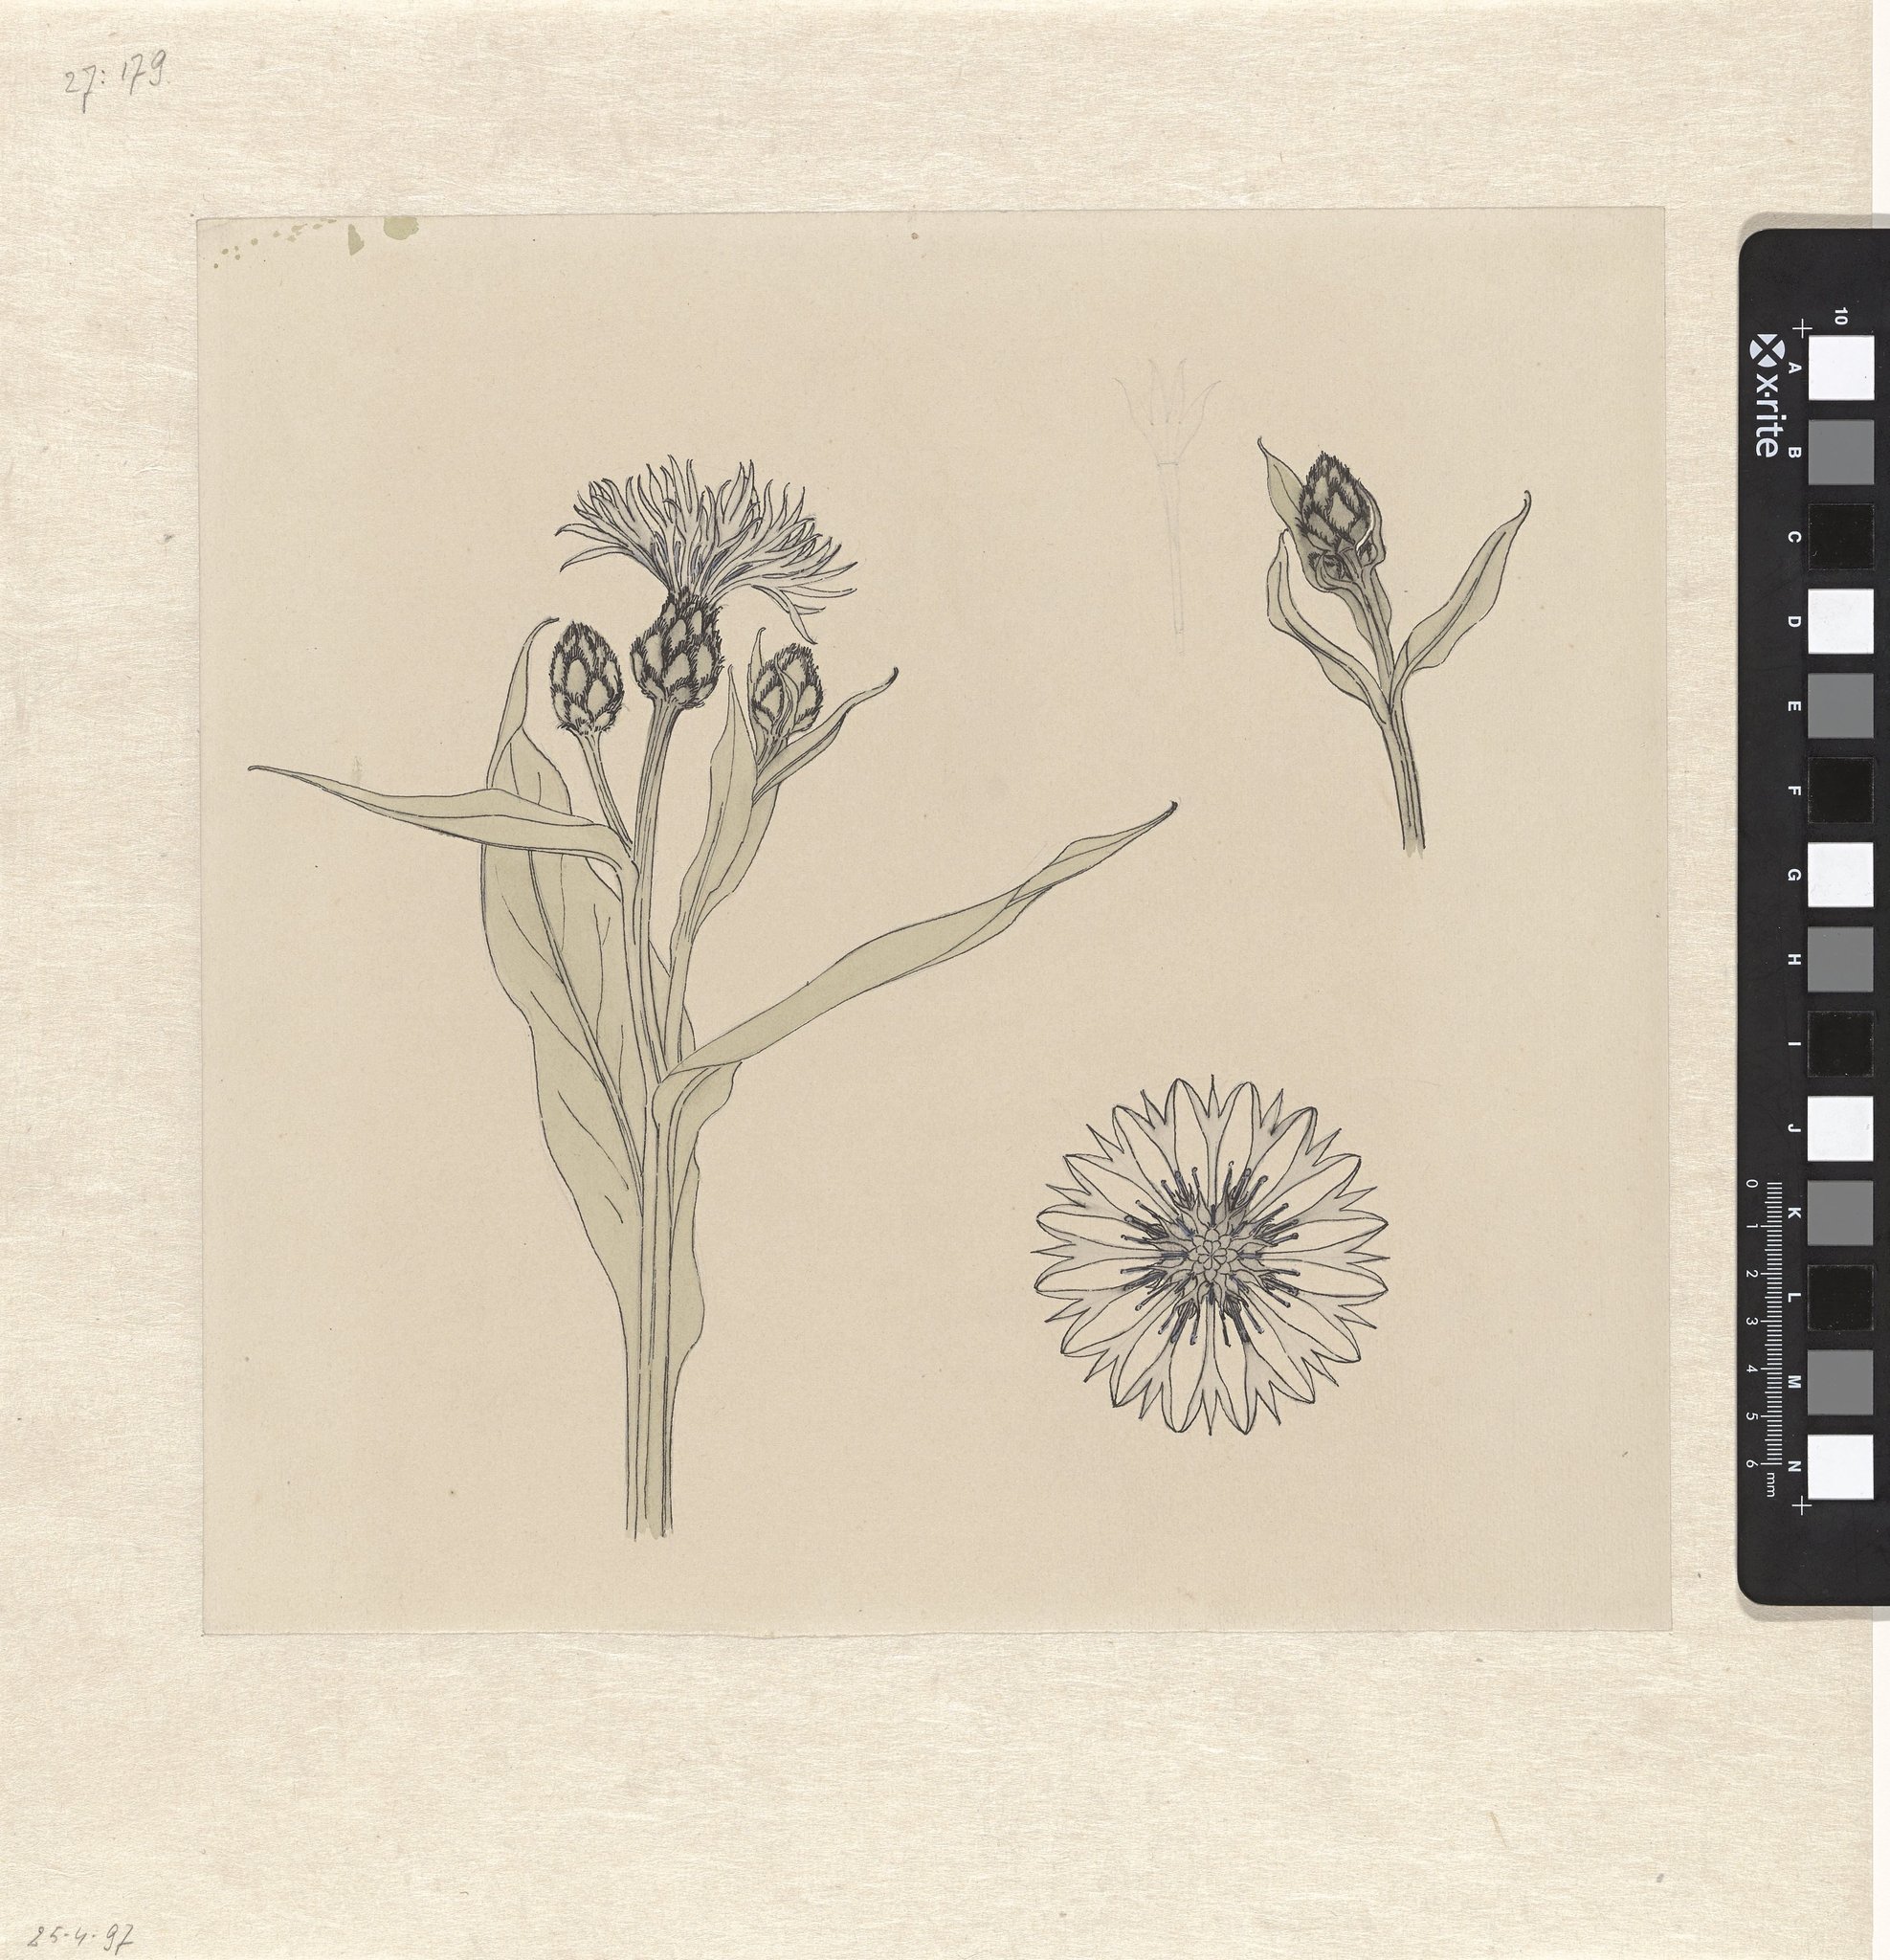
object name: drawing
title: Studies van korenbloemen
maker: julie de graag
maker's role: draughtsman, print maker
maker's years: 1877-1924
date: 1887-1924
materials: ink, paper, pencil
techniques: brush, pen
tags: flowers: cornflower